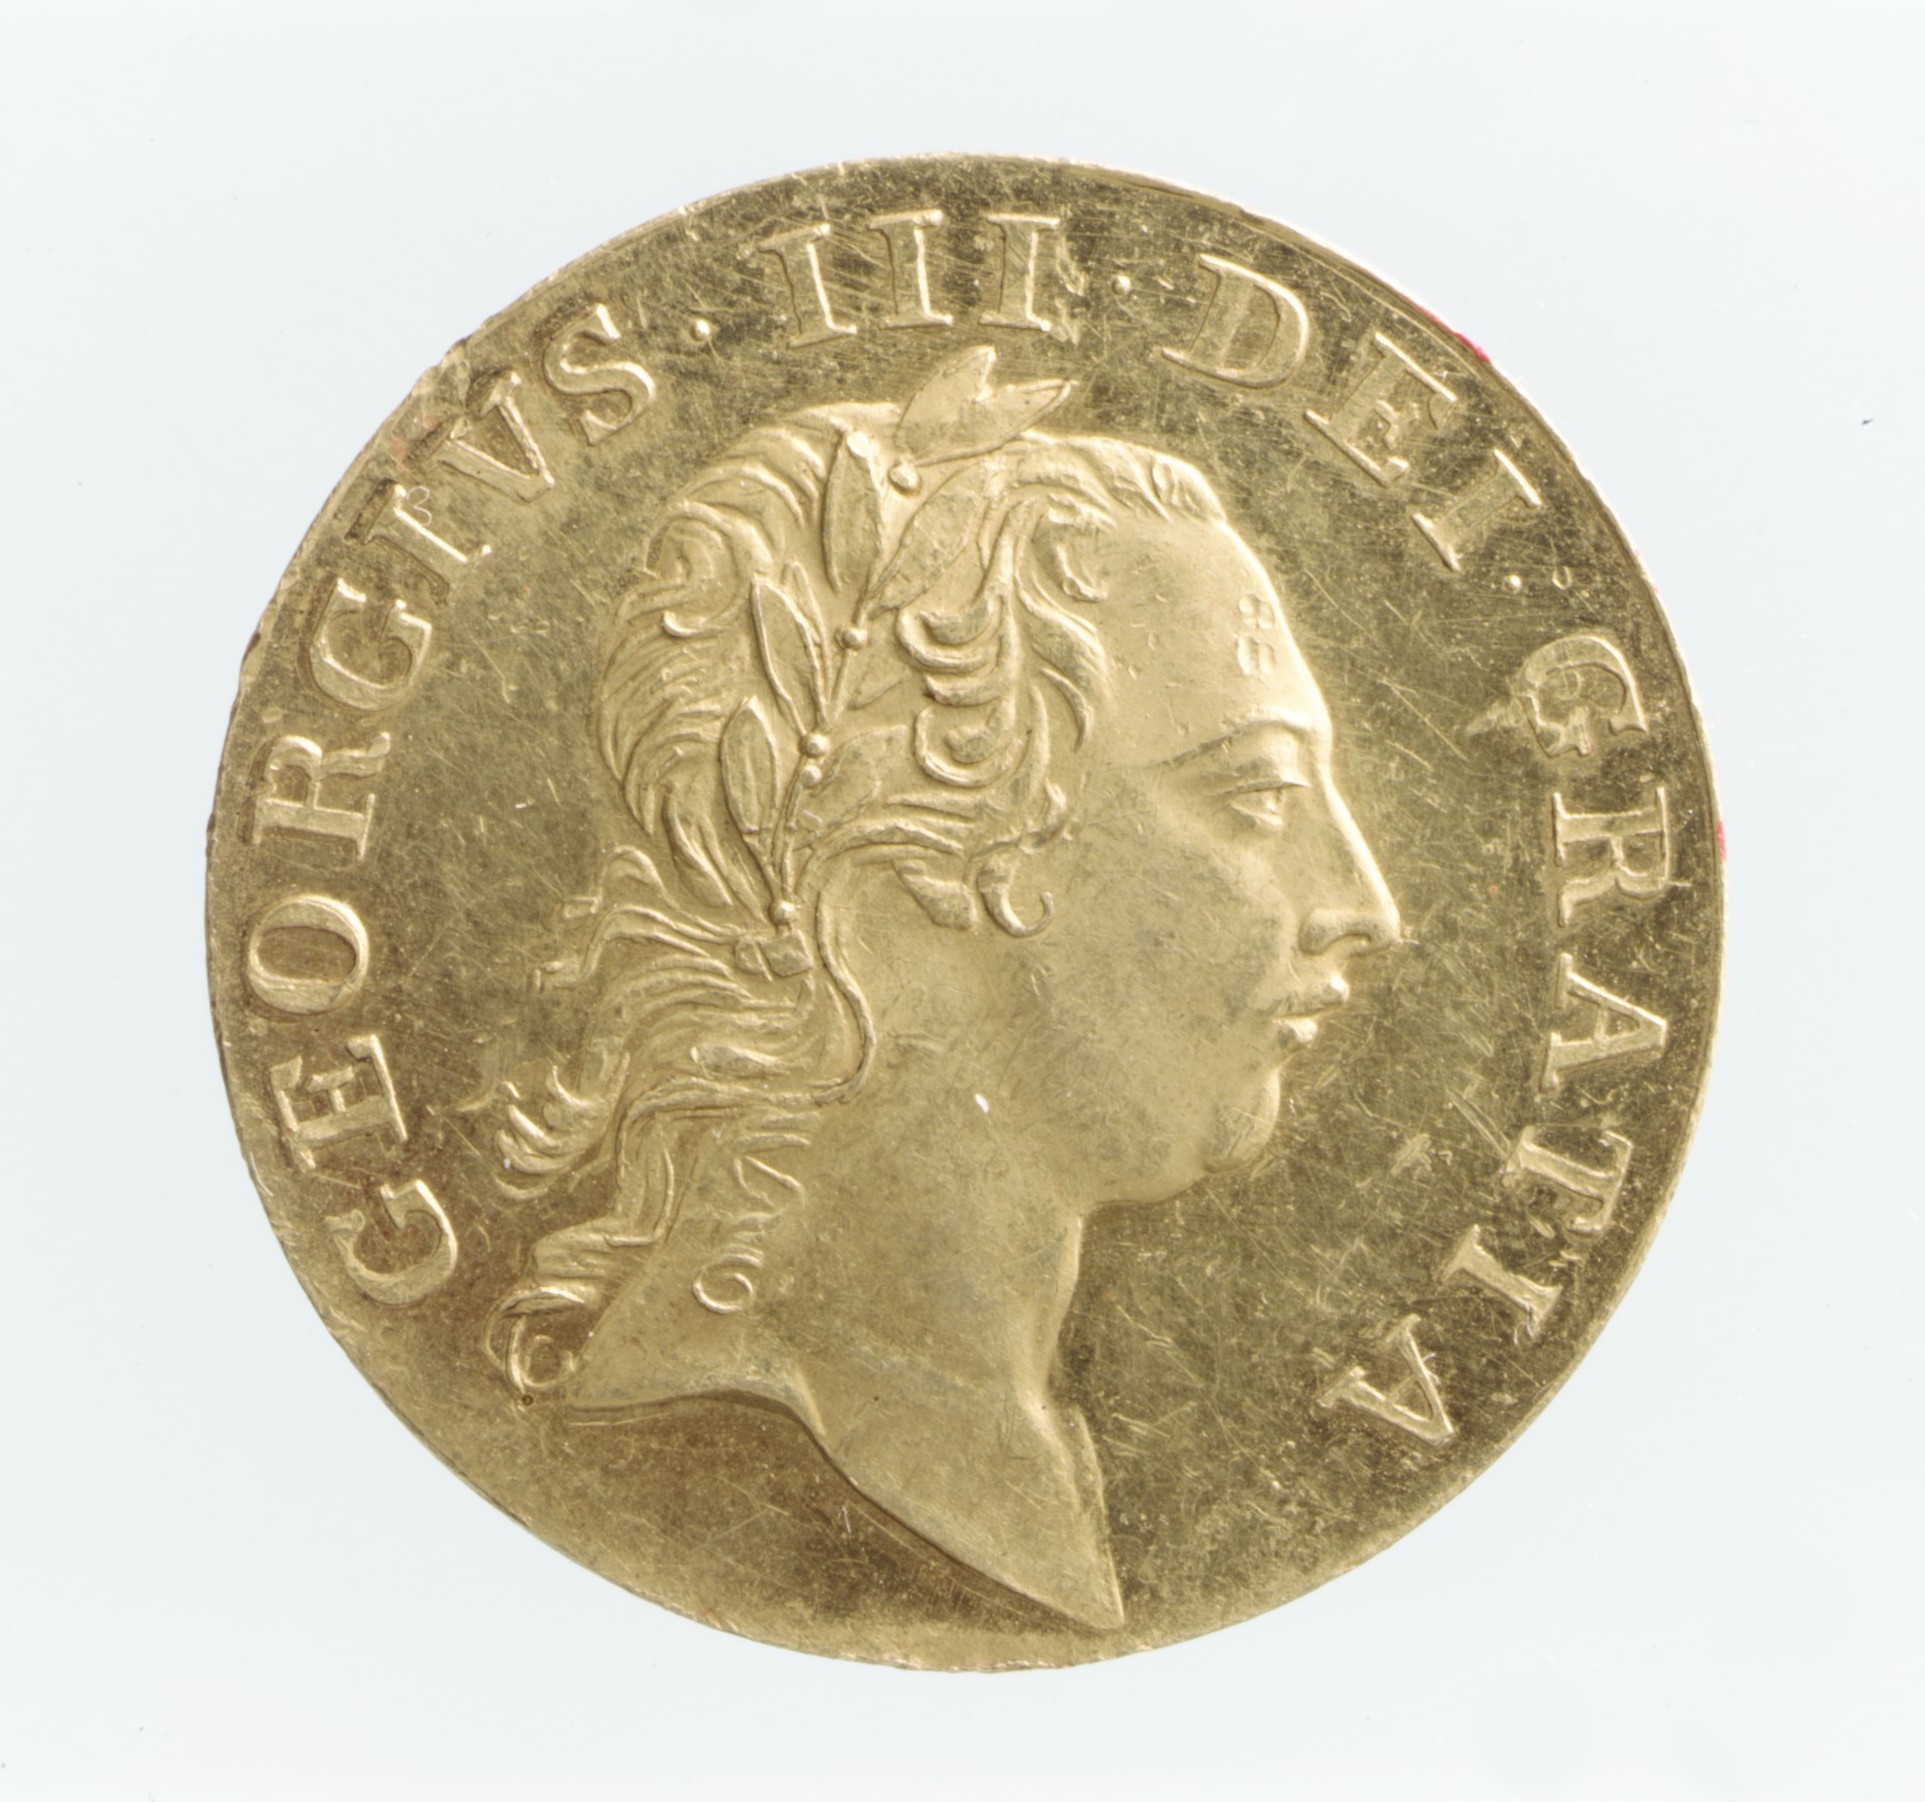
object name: proof guinea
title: Proof guinea of George III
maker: richard yeo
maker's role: maker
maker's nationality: british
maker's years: 1720-1779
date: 1761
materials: gold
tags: kings,profiles,coins,coat of arms